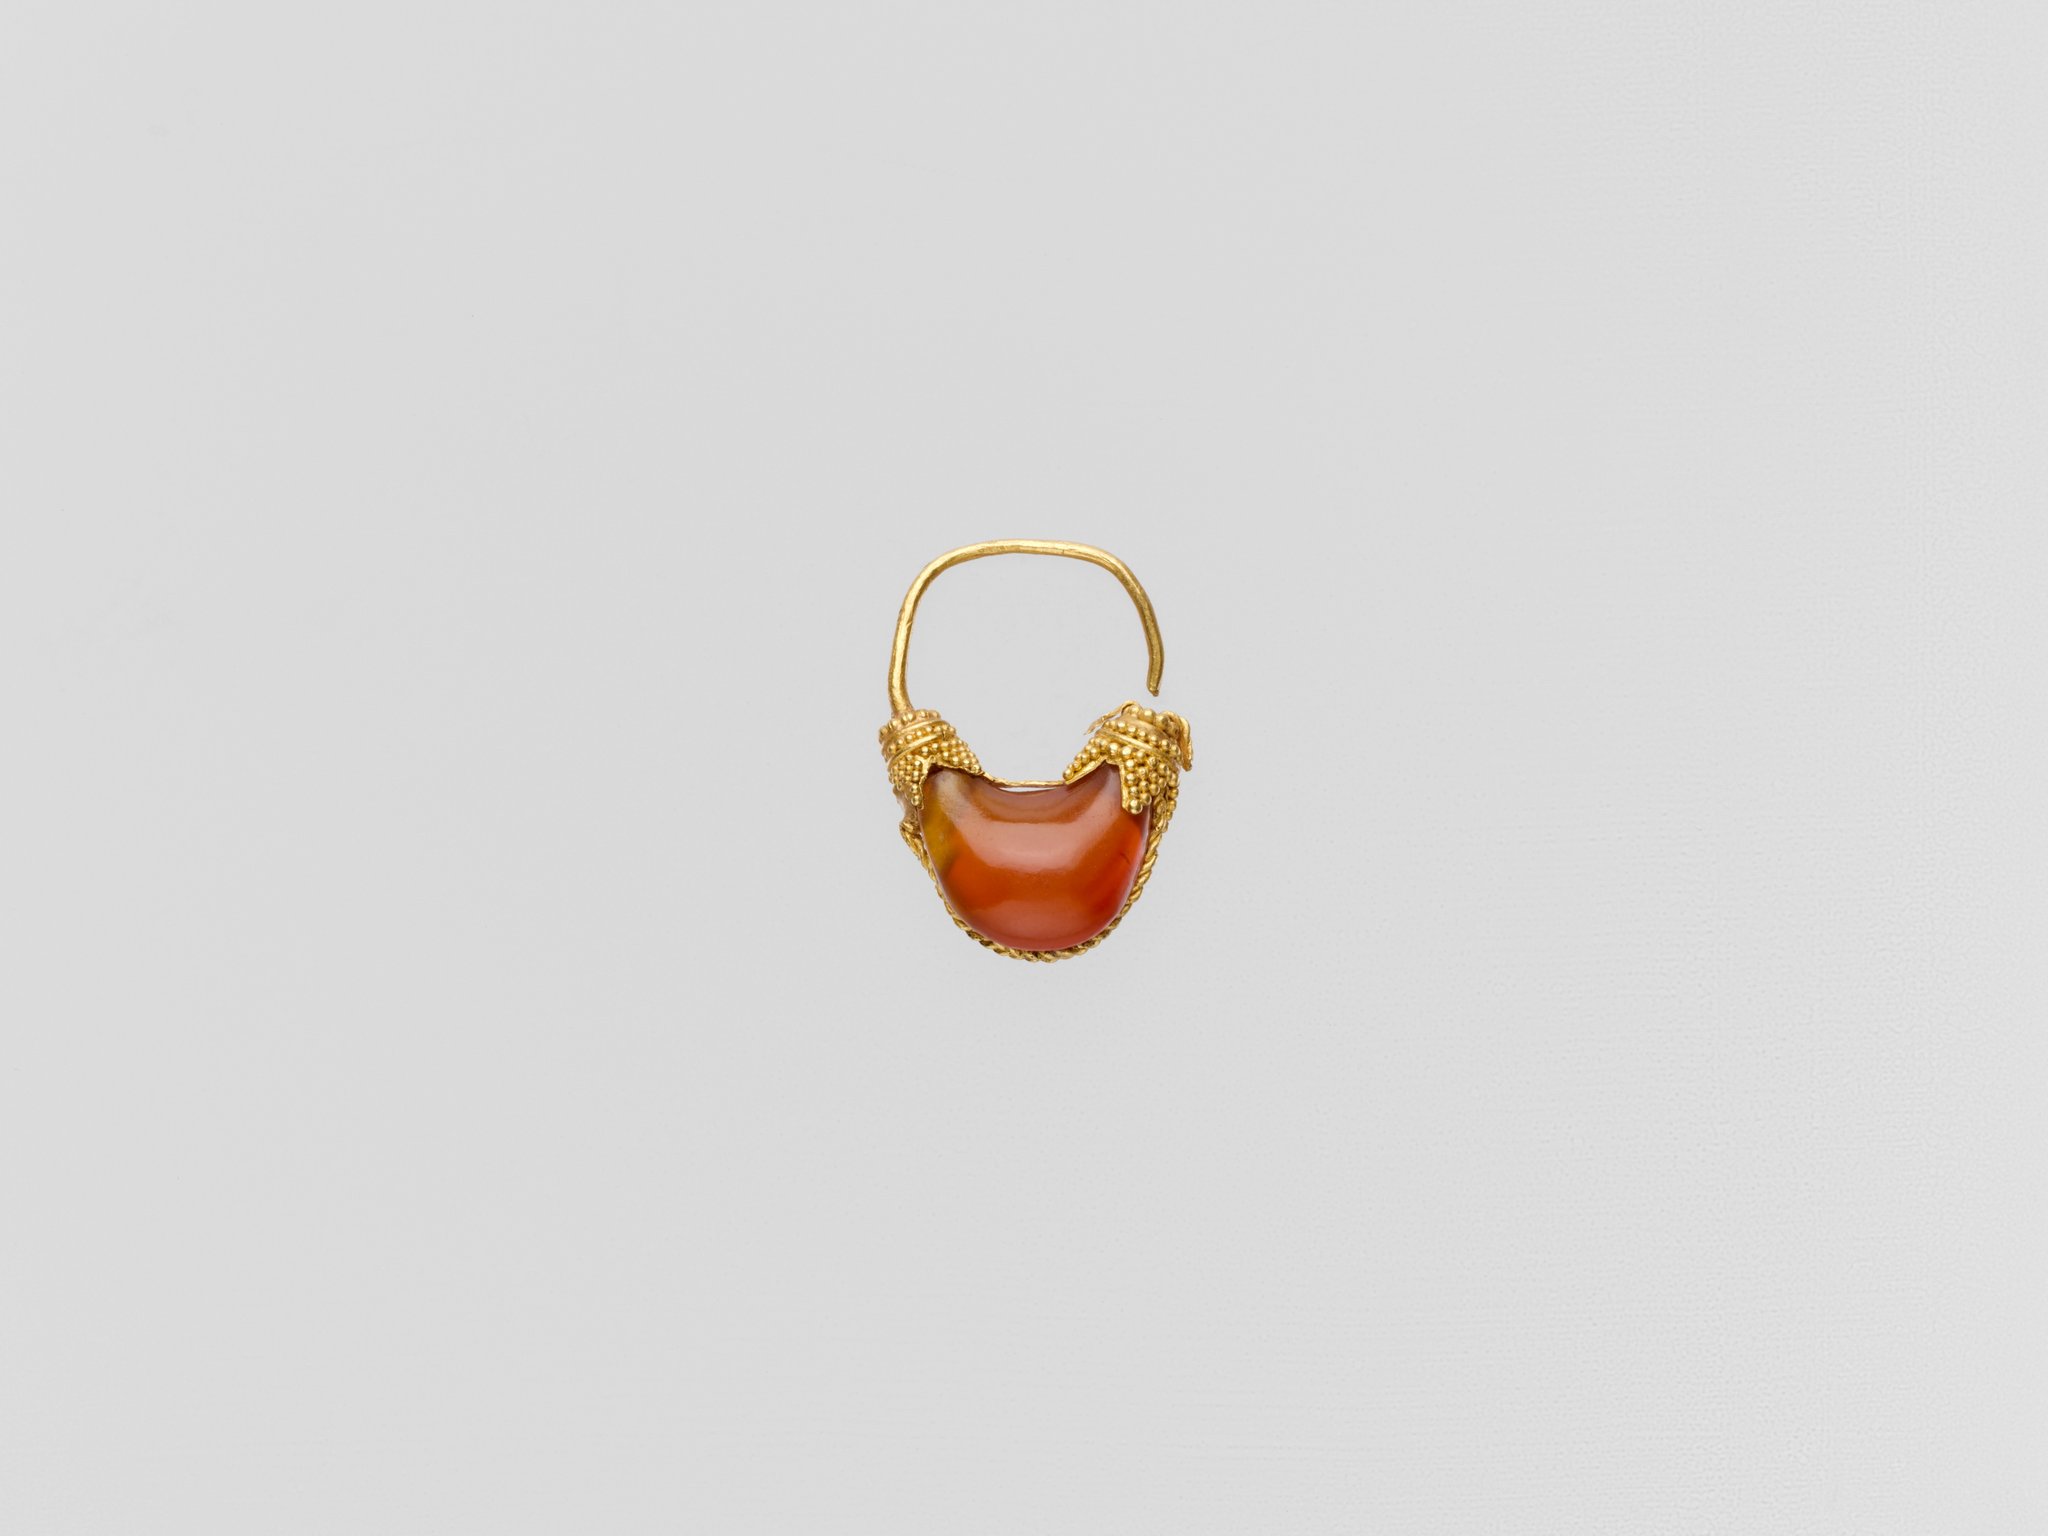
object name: earring, boat shaped with carnelian setting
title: Gold and carnelian boat-shaped earring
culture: cypriot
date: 600-401 BCE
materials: gemstone, gold